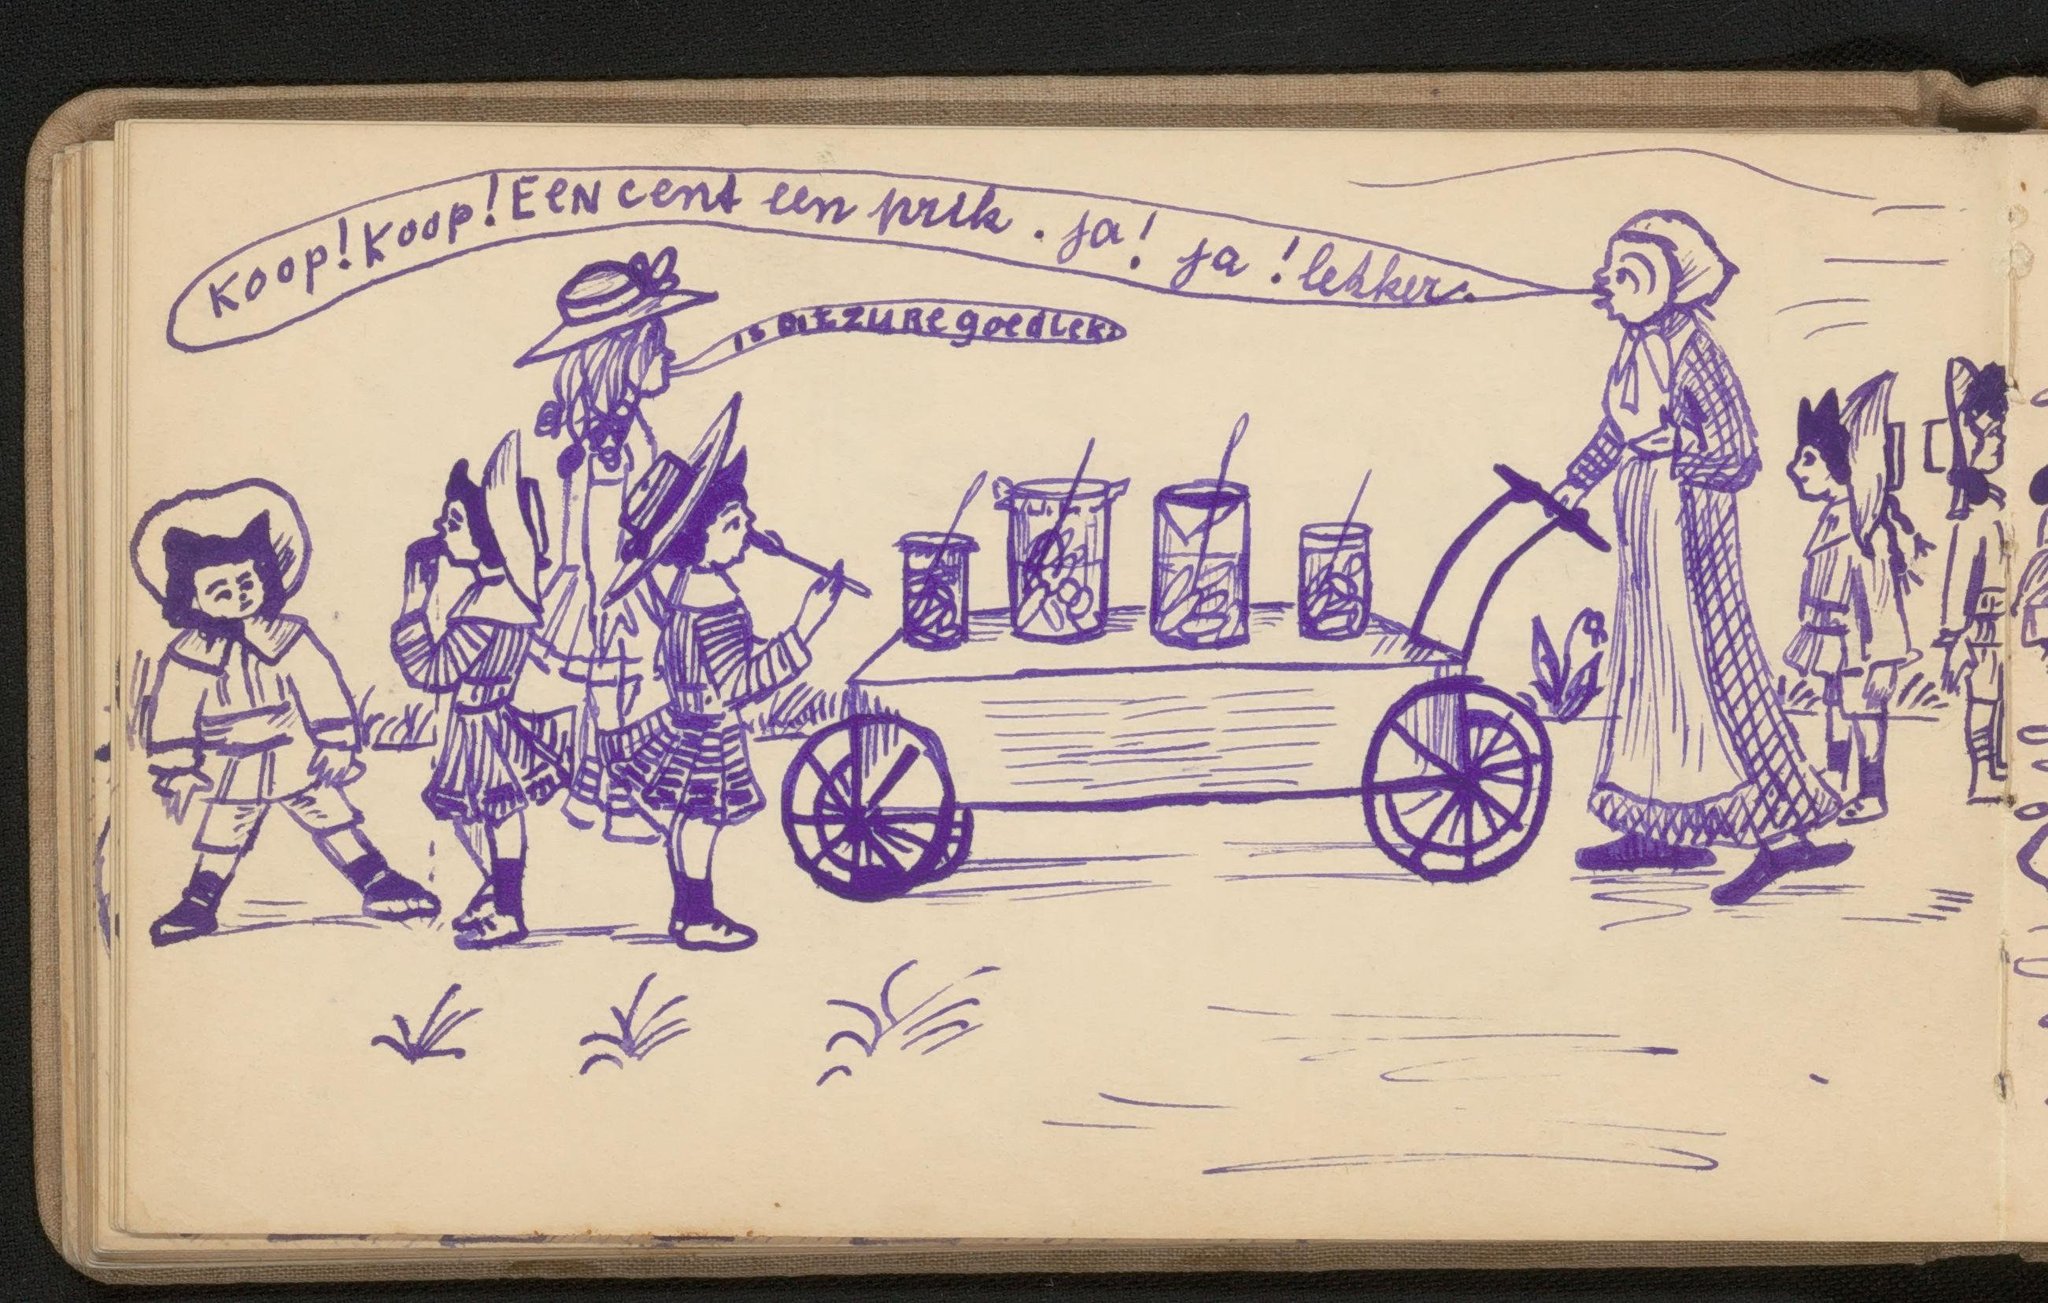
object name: sketchbook leaf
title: Verkoopster van zuur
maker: Anonymous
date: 1875-1920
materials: ink, paper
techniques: pen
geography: netherlands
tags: fruits: cucumber, street-trader - bb - women engaged in trade and commerce, processed vegetables (pickles) (+ foodstuffs in a glass)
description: De kinderen krijgen een augurk bij de kar van de verkoopster. Onderdeel van het schetsboek met humoristische tekeningen over het leven van een 'famille nombreuse'. Onderwerpsrubrieken binnen de Atlas Zeden en Gewoonten: Zeden en Gewoonten in Engeren Zin, Des menschen beging, midden en einde, Kinderleven.